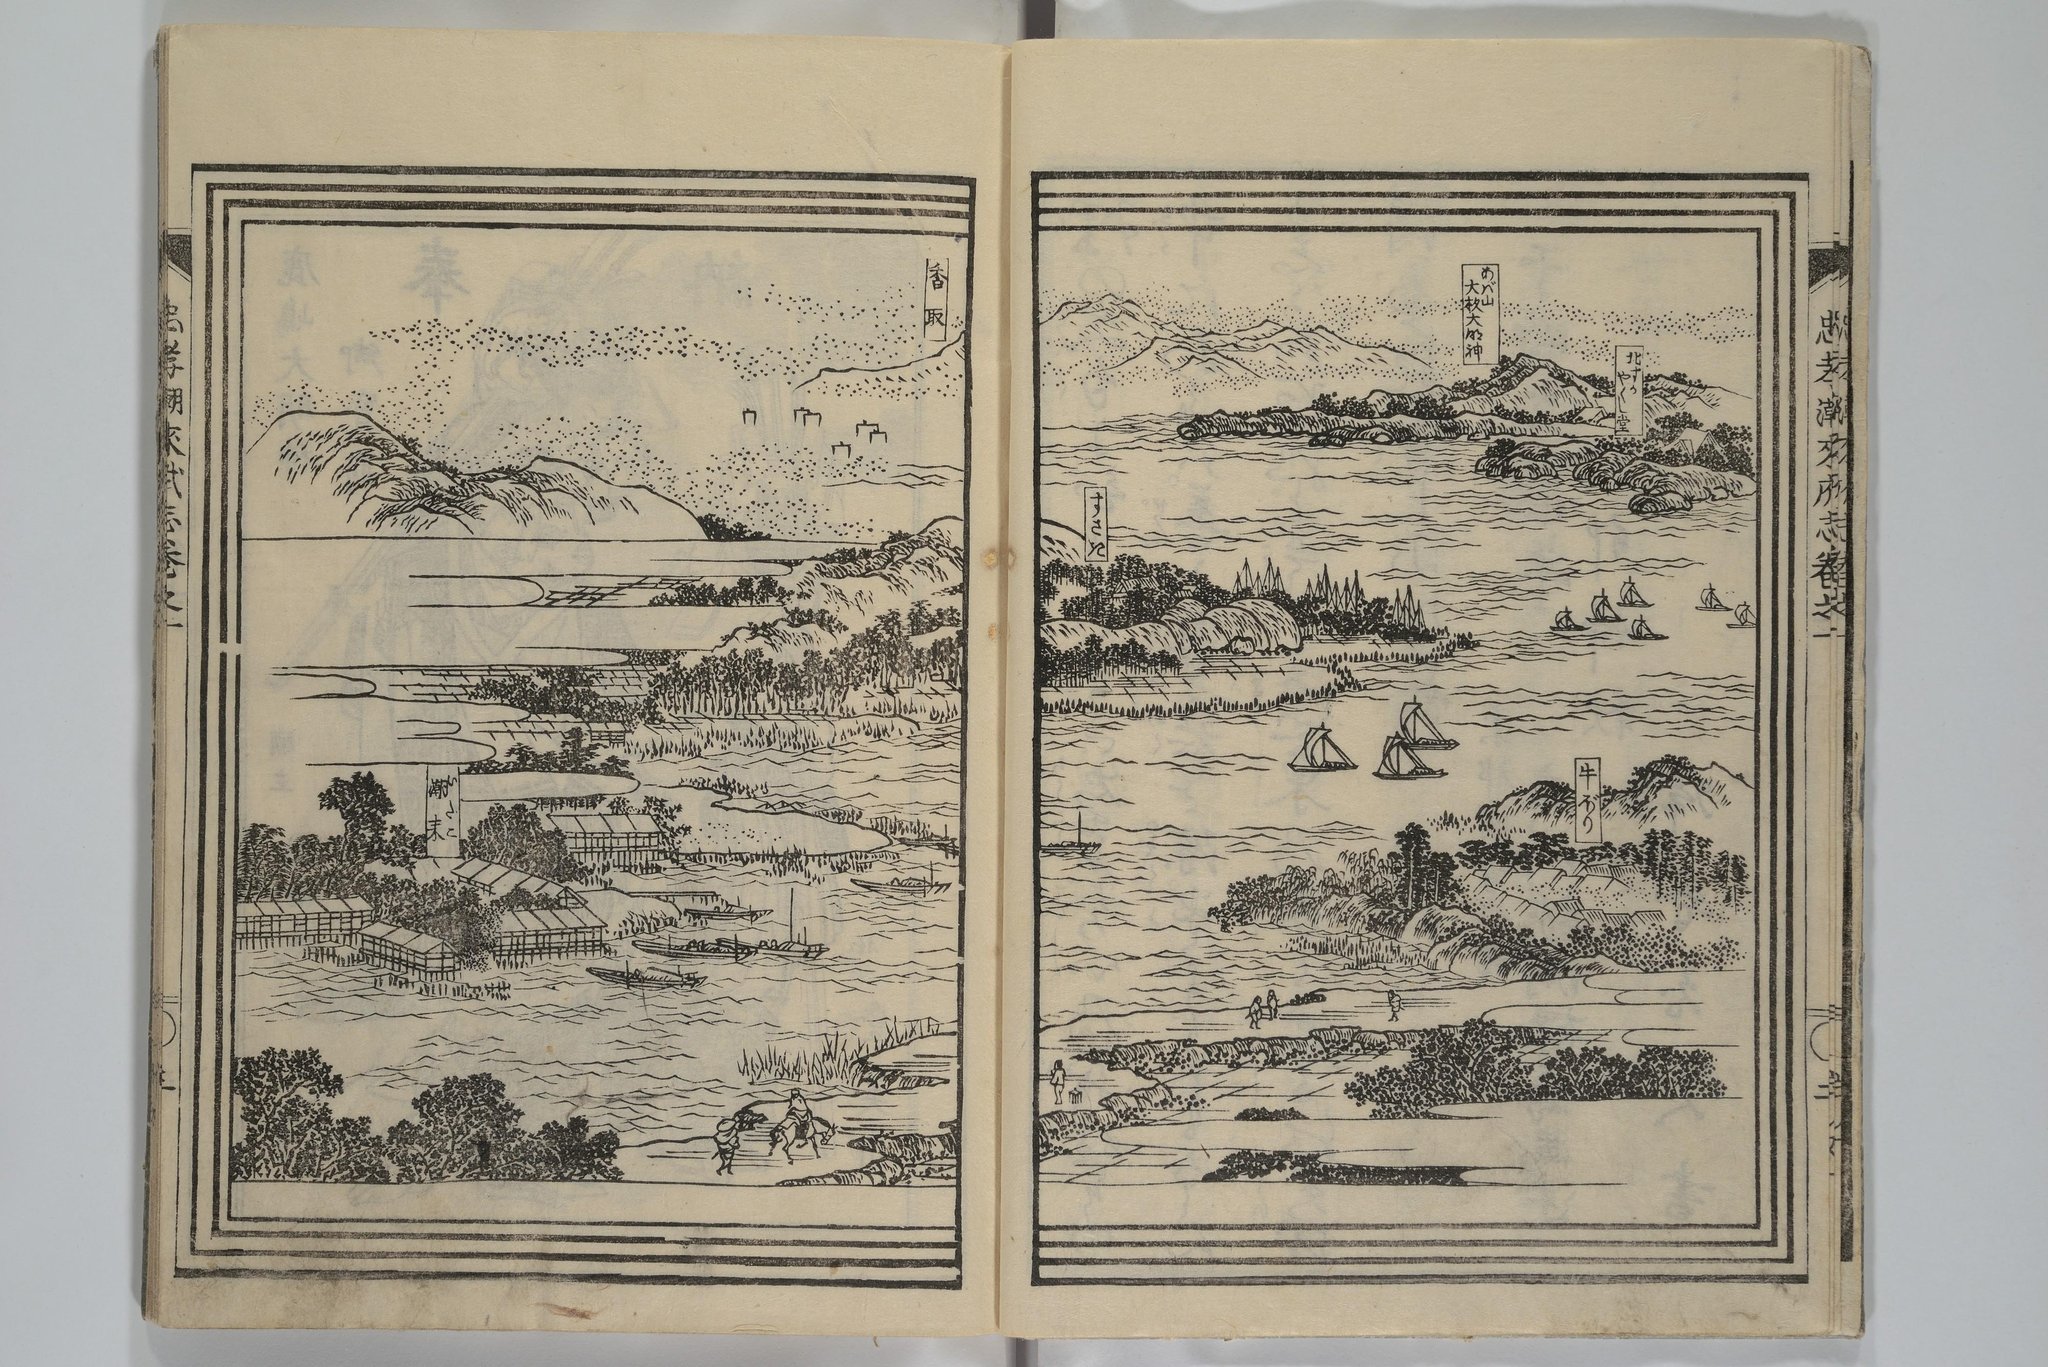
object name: illustrated book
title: Loyal Songs of Itako (Chūkō itakobushi) 忠孝潮来府志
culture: japanese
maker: katsushika hokusai 葛飾北斎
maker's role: artist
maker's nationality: japanese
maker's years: 1760-1849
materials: ink, paper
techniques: woodblock print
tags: houses,horses,landscapes,boats